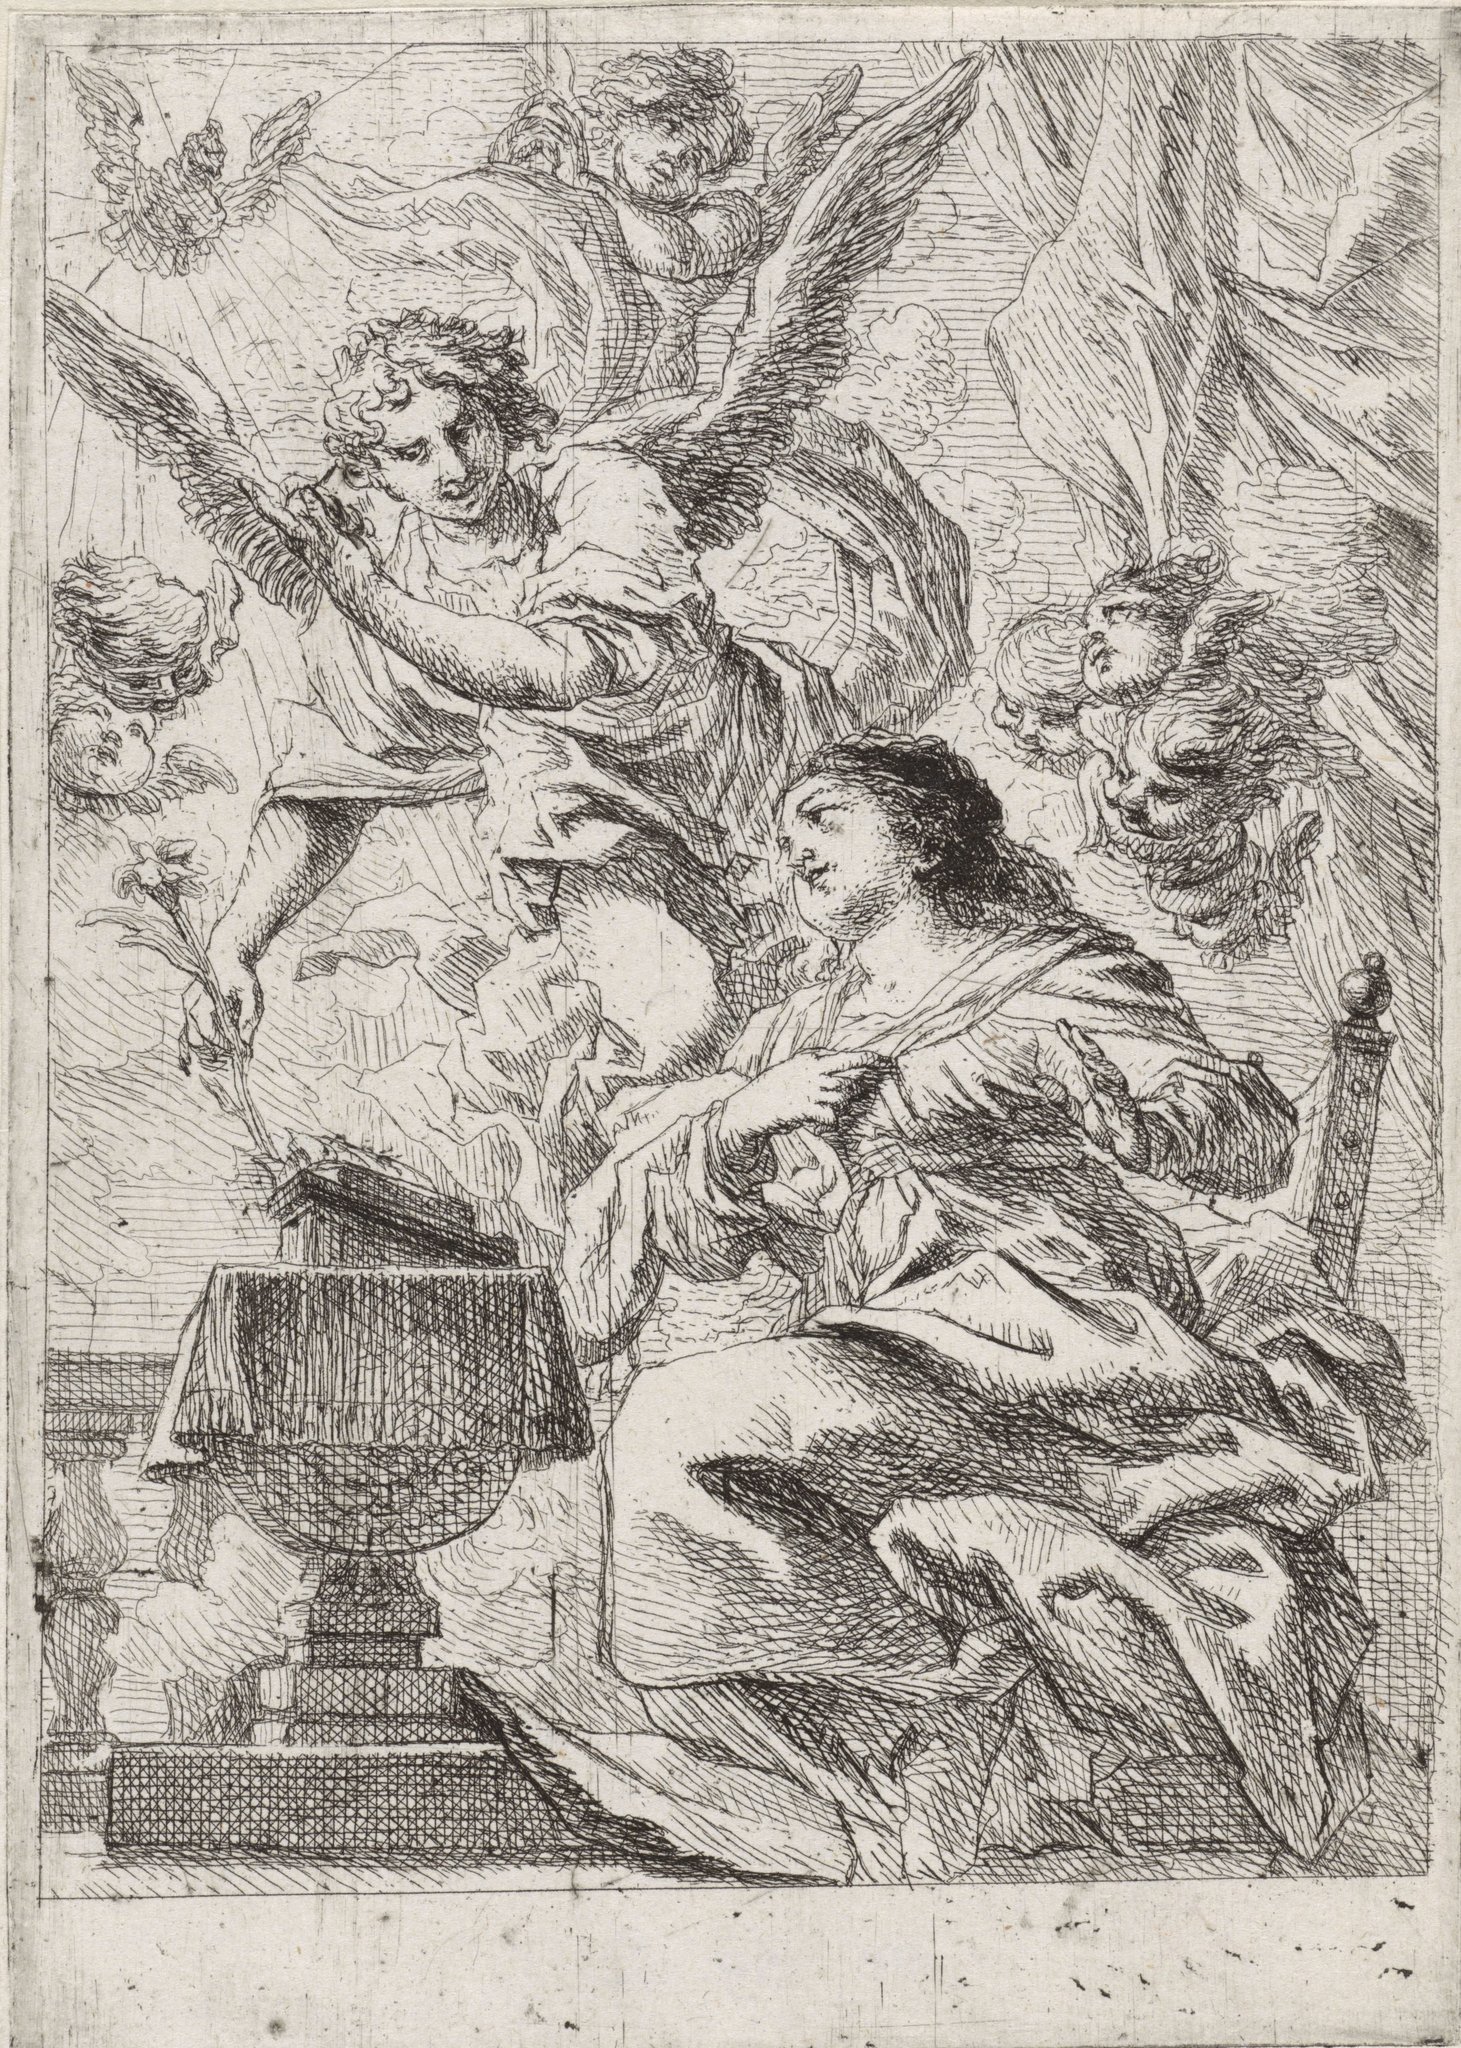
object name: print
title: Annunciatie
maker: cornelis schut (i)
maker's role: draughtsman, print maker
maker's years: 1597-1655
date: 1618-1655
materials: paper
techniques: etching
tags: the annunciation: mary, usually reading, is visited by the angel (sometimes a woman overhears the conversation)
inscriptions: collector's mark: Lugt 240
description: Maria zit op aan een tafel met daarop een opengeslagen boek. Zij kijkt op naar de engel Gabriël boven haar, die een lelie in de hand houdt. Gabriël wordt vergezeld door putti. De duif daalt neer langs een lichtstraal.